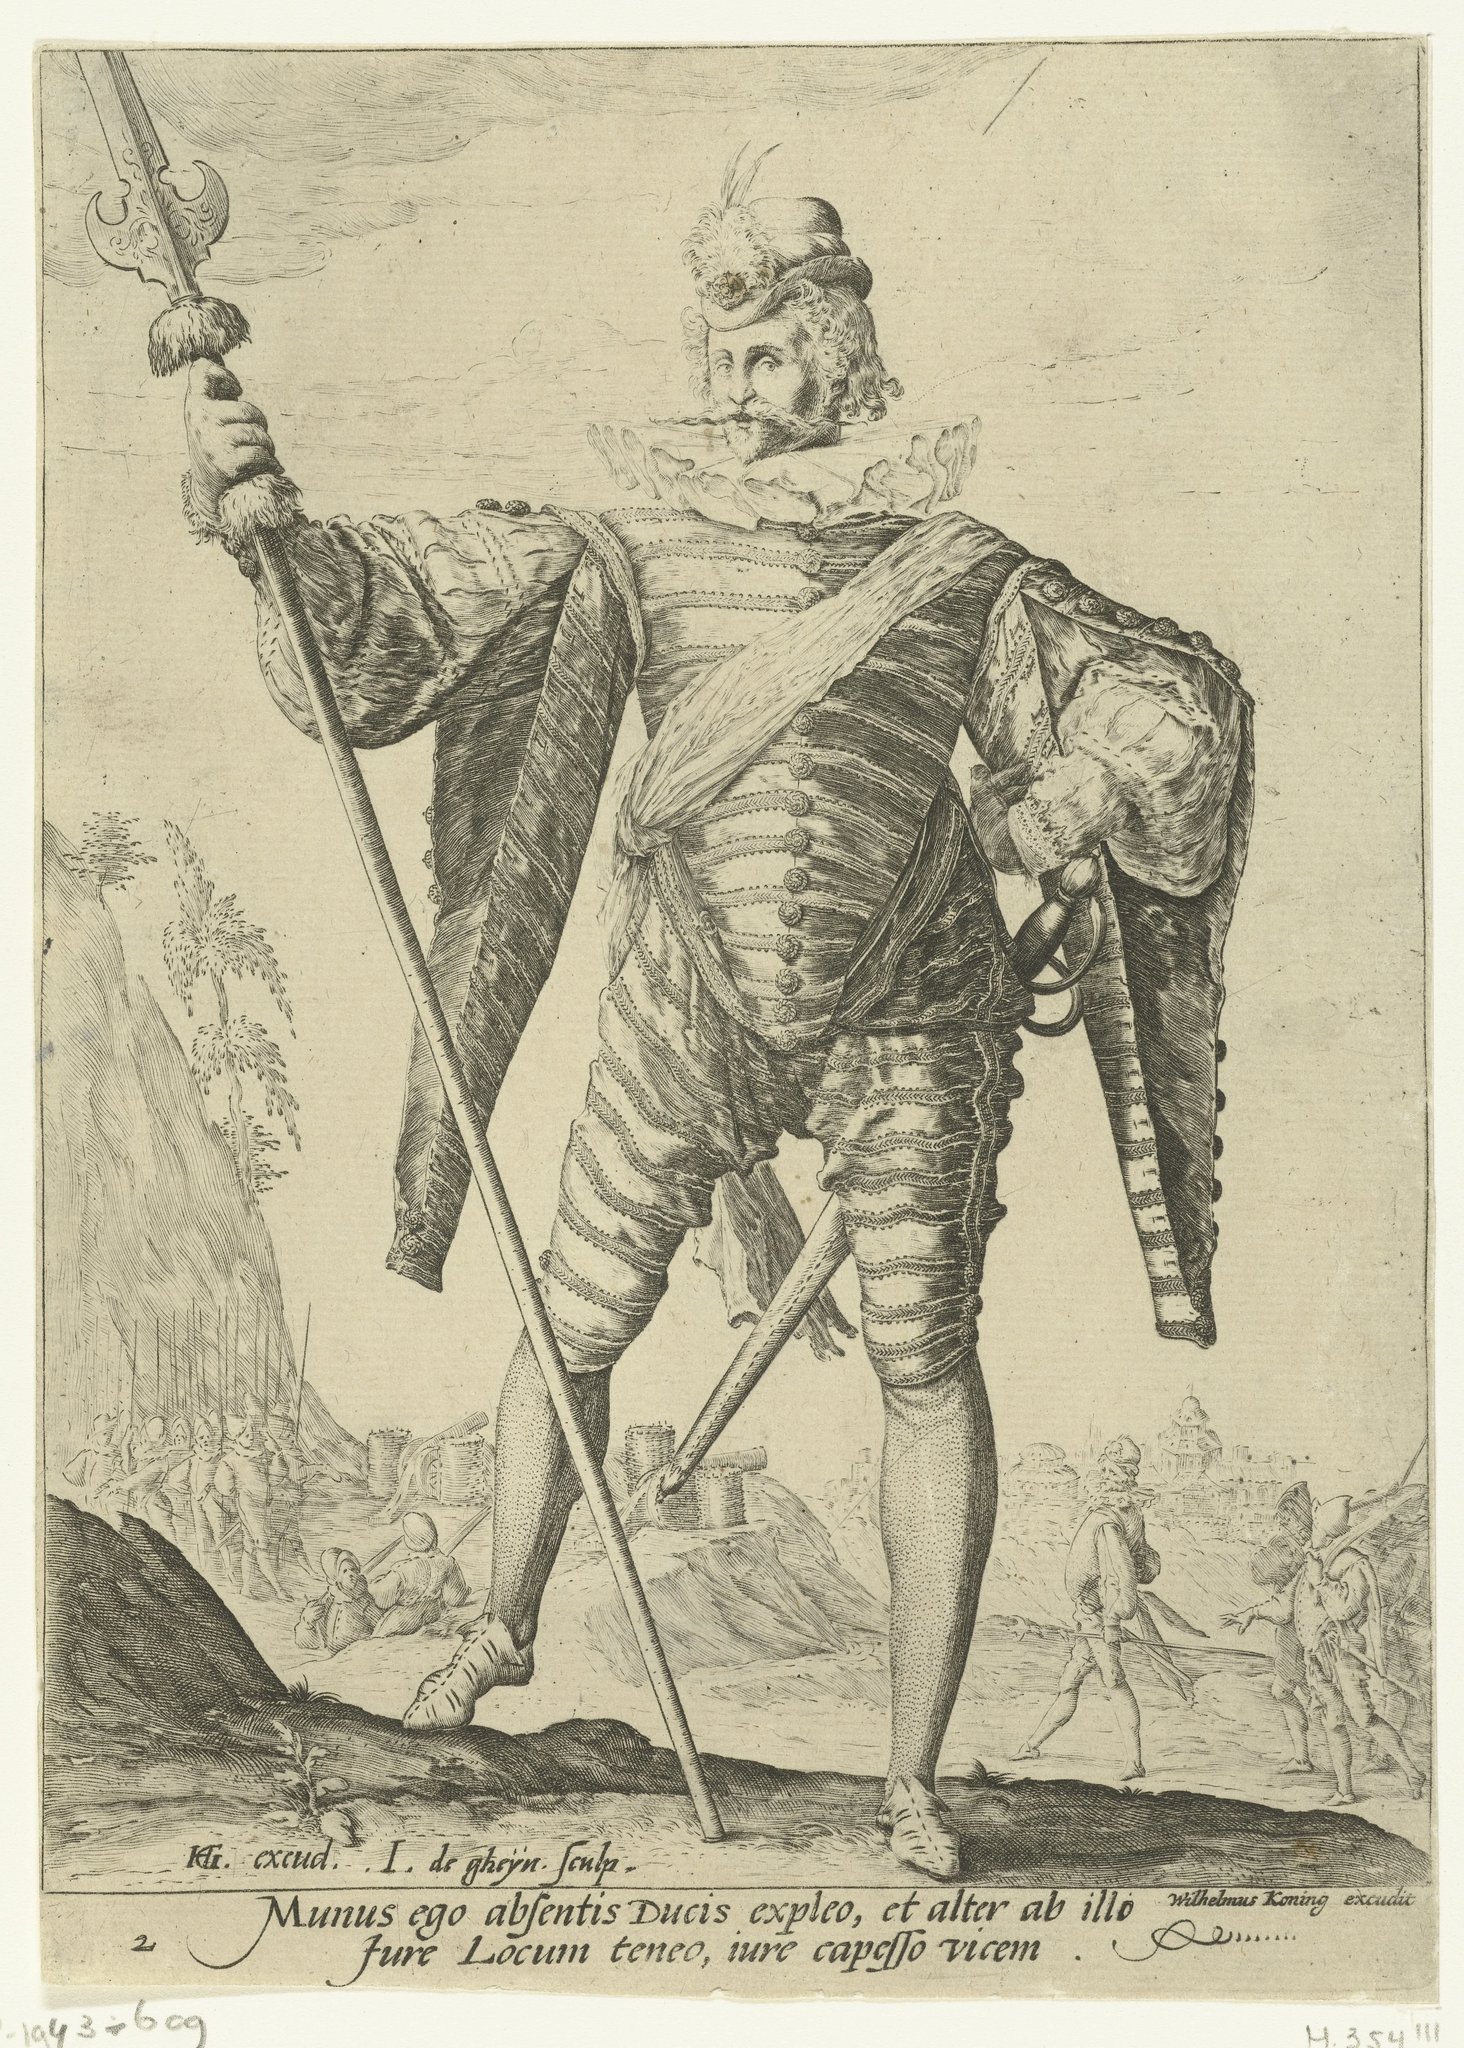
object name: print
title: Luitenant-kolonel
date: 1587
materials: paper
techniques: engraving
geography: amsterdam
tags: siege, position war, helved weapons, polearms (for striking, hacking, thrusting), officer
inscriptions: collector's mark: Lugt 2228a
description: Een man in militaire uitdossing (een luitenant-kolonel), ten voeten uit, een zwaard aan zijn gordel, een stokwapen (partizaan) in zijn rechterhand. Op de achtergrond een heuvelachtig landschap waarin een stad belegerd wordt. Onder de voorstelling twee regels tekst in Latijn. Deze prent is onderdeel van een serie van 12 genummerde prenten van militairen, ten voeten uit weergegeven tegen een landschappelijke achtergrond waarin krijgshandelingen verricht worden, en met een tweeregelig Latijns onderschrift.